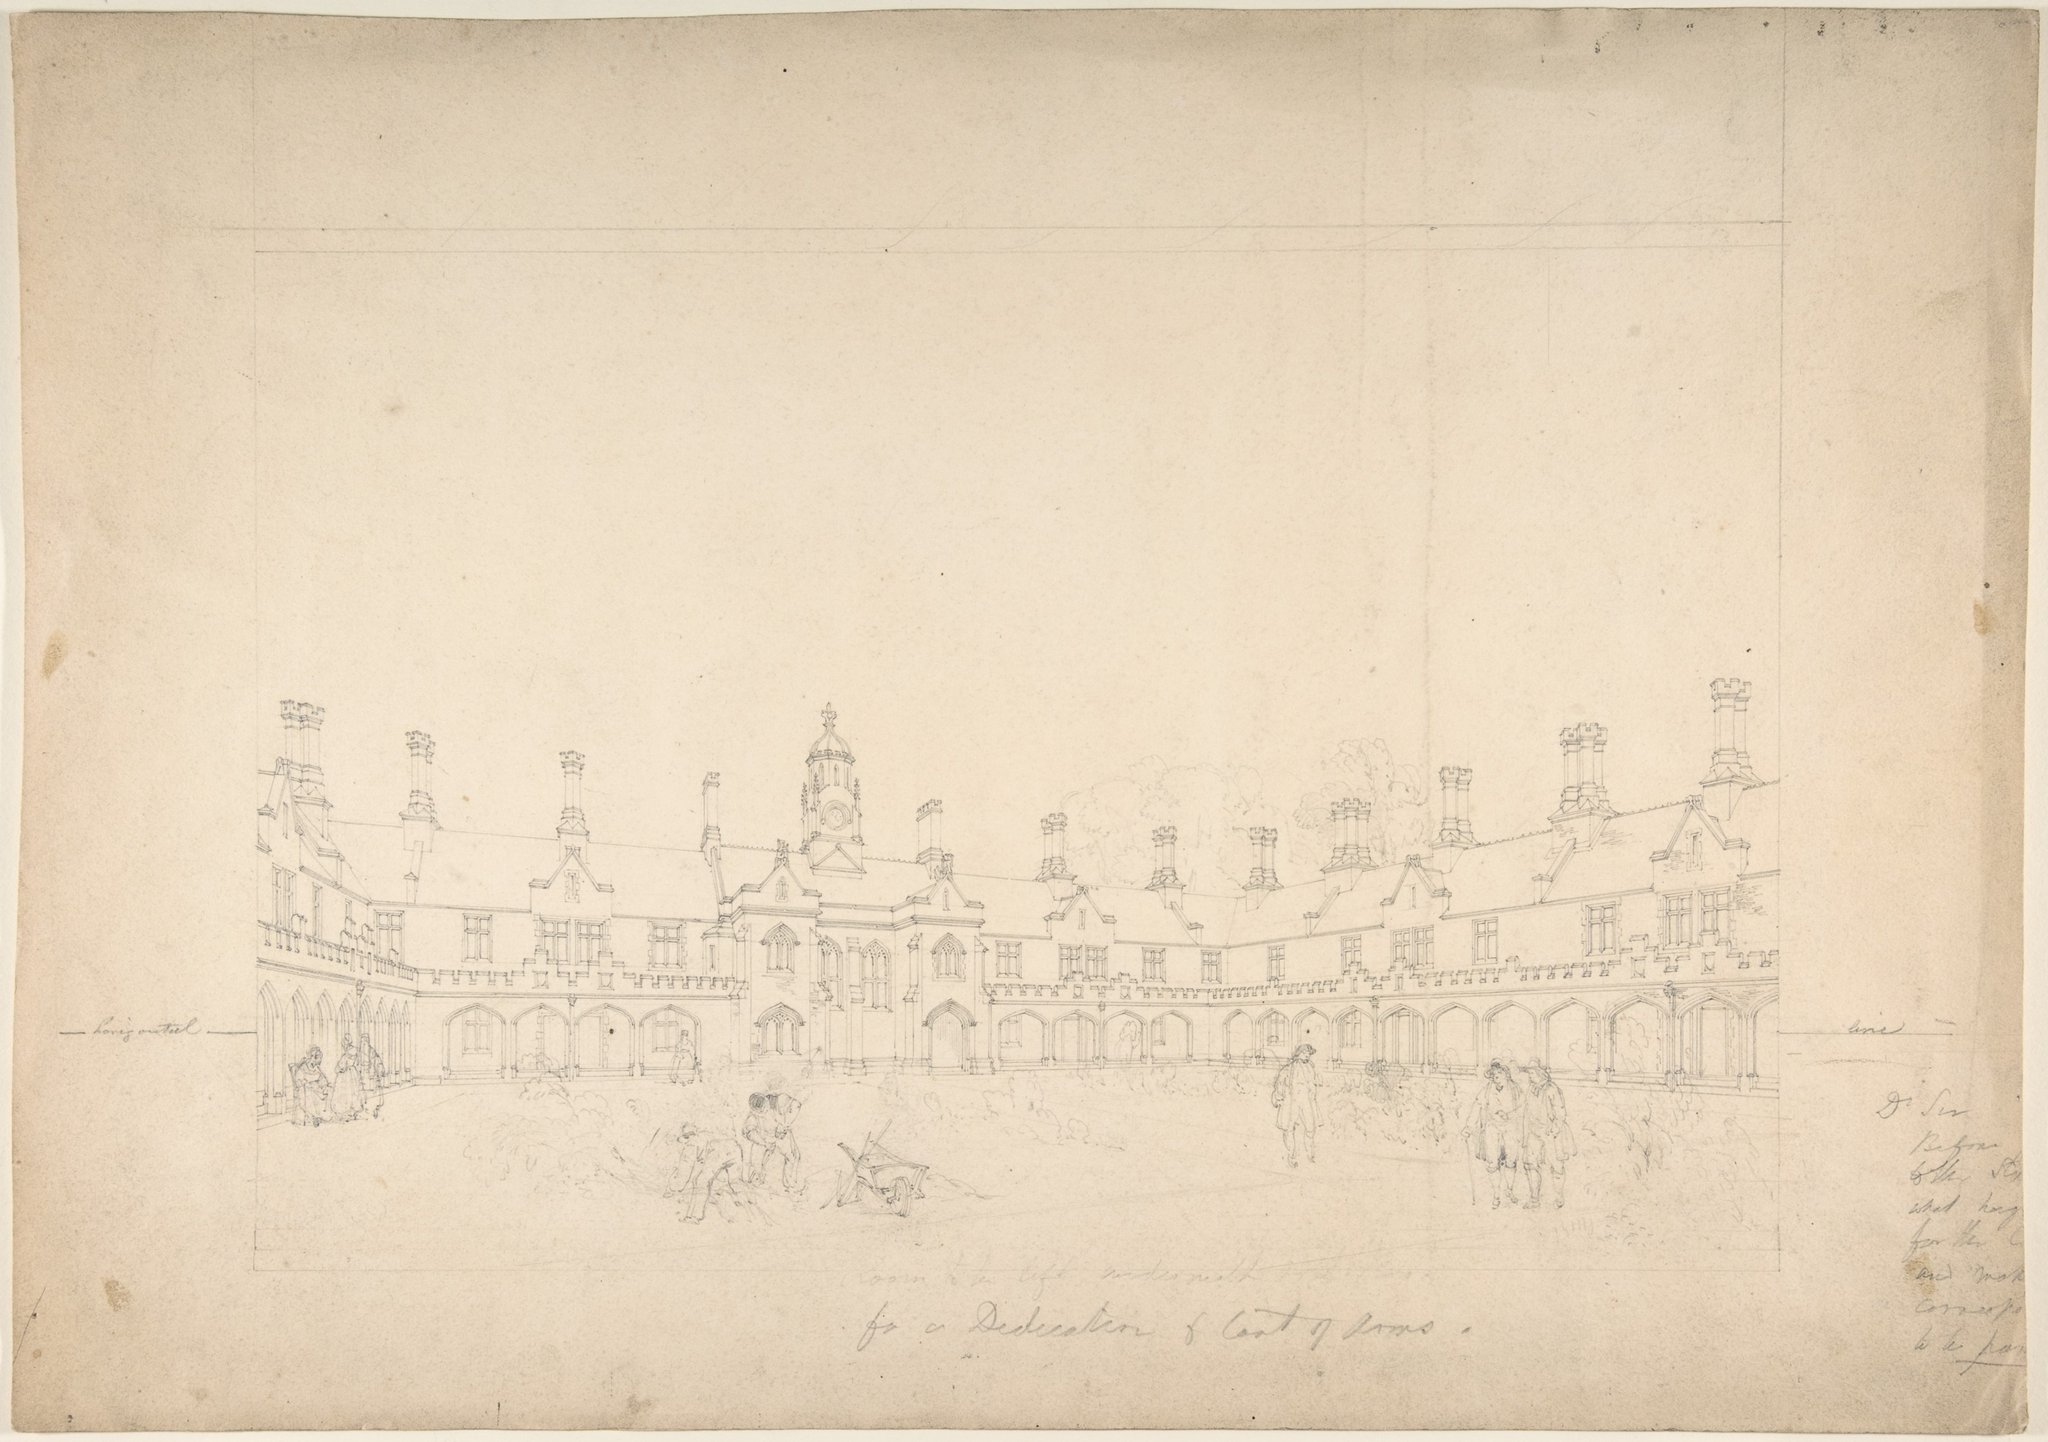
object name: drawing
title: View of a Courtyard Surrounded by Buildings in Gothic Style with Central Clock Tower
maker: anonymous, british, 19th century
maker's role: artist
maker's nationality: british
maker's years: 1800-1900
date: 1801-1900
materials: graphite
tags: human figures,buildings,towers,courtyards